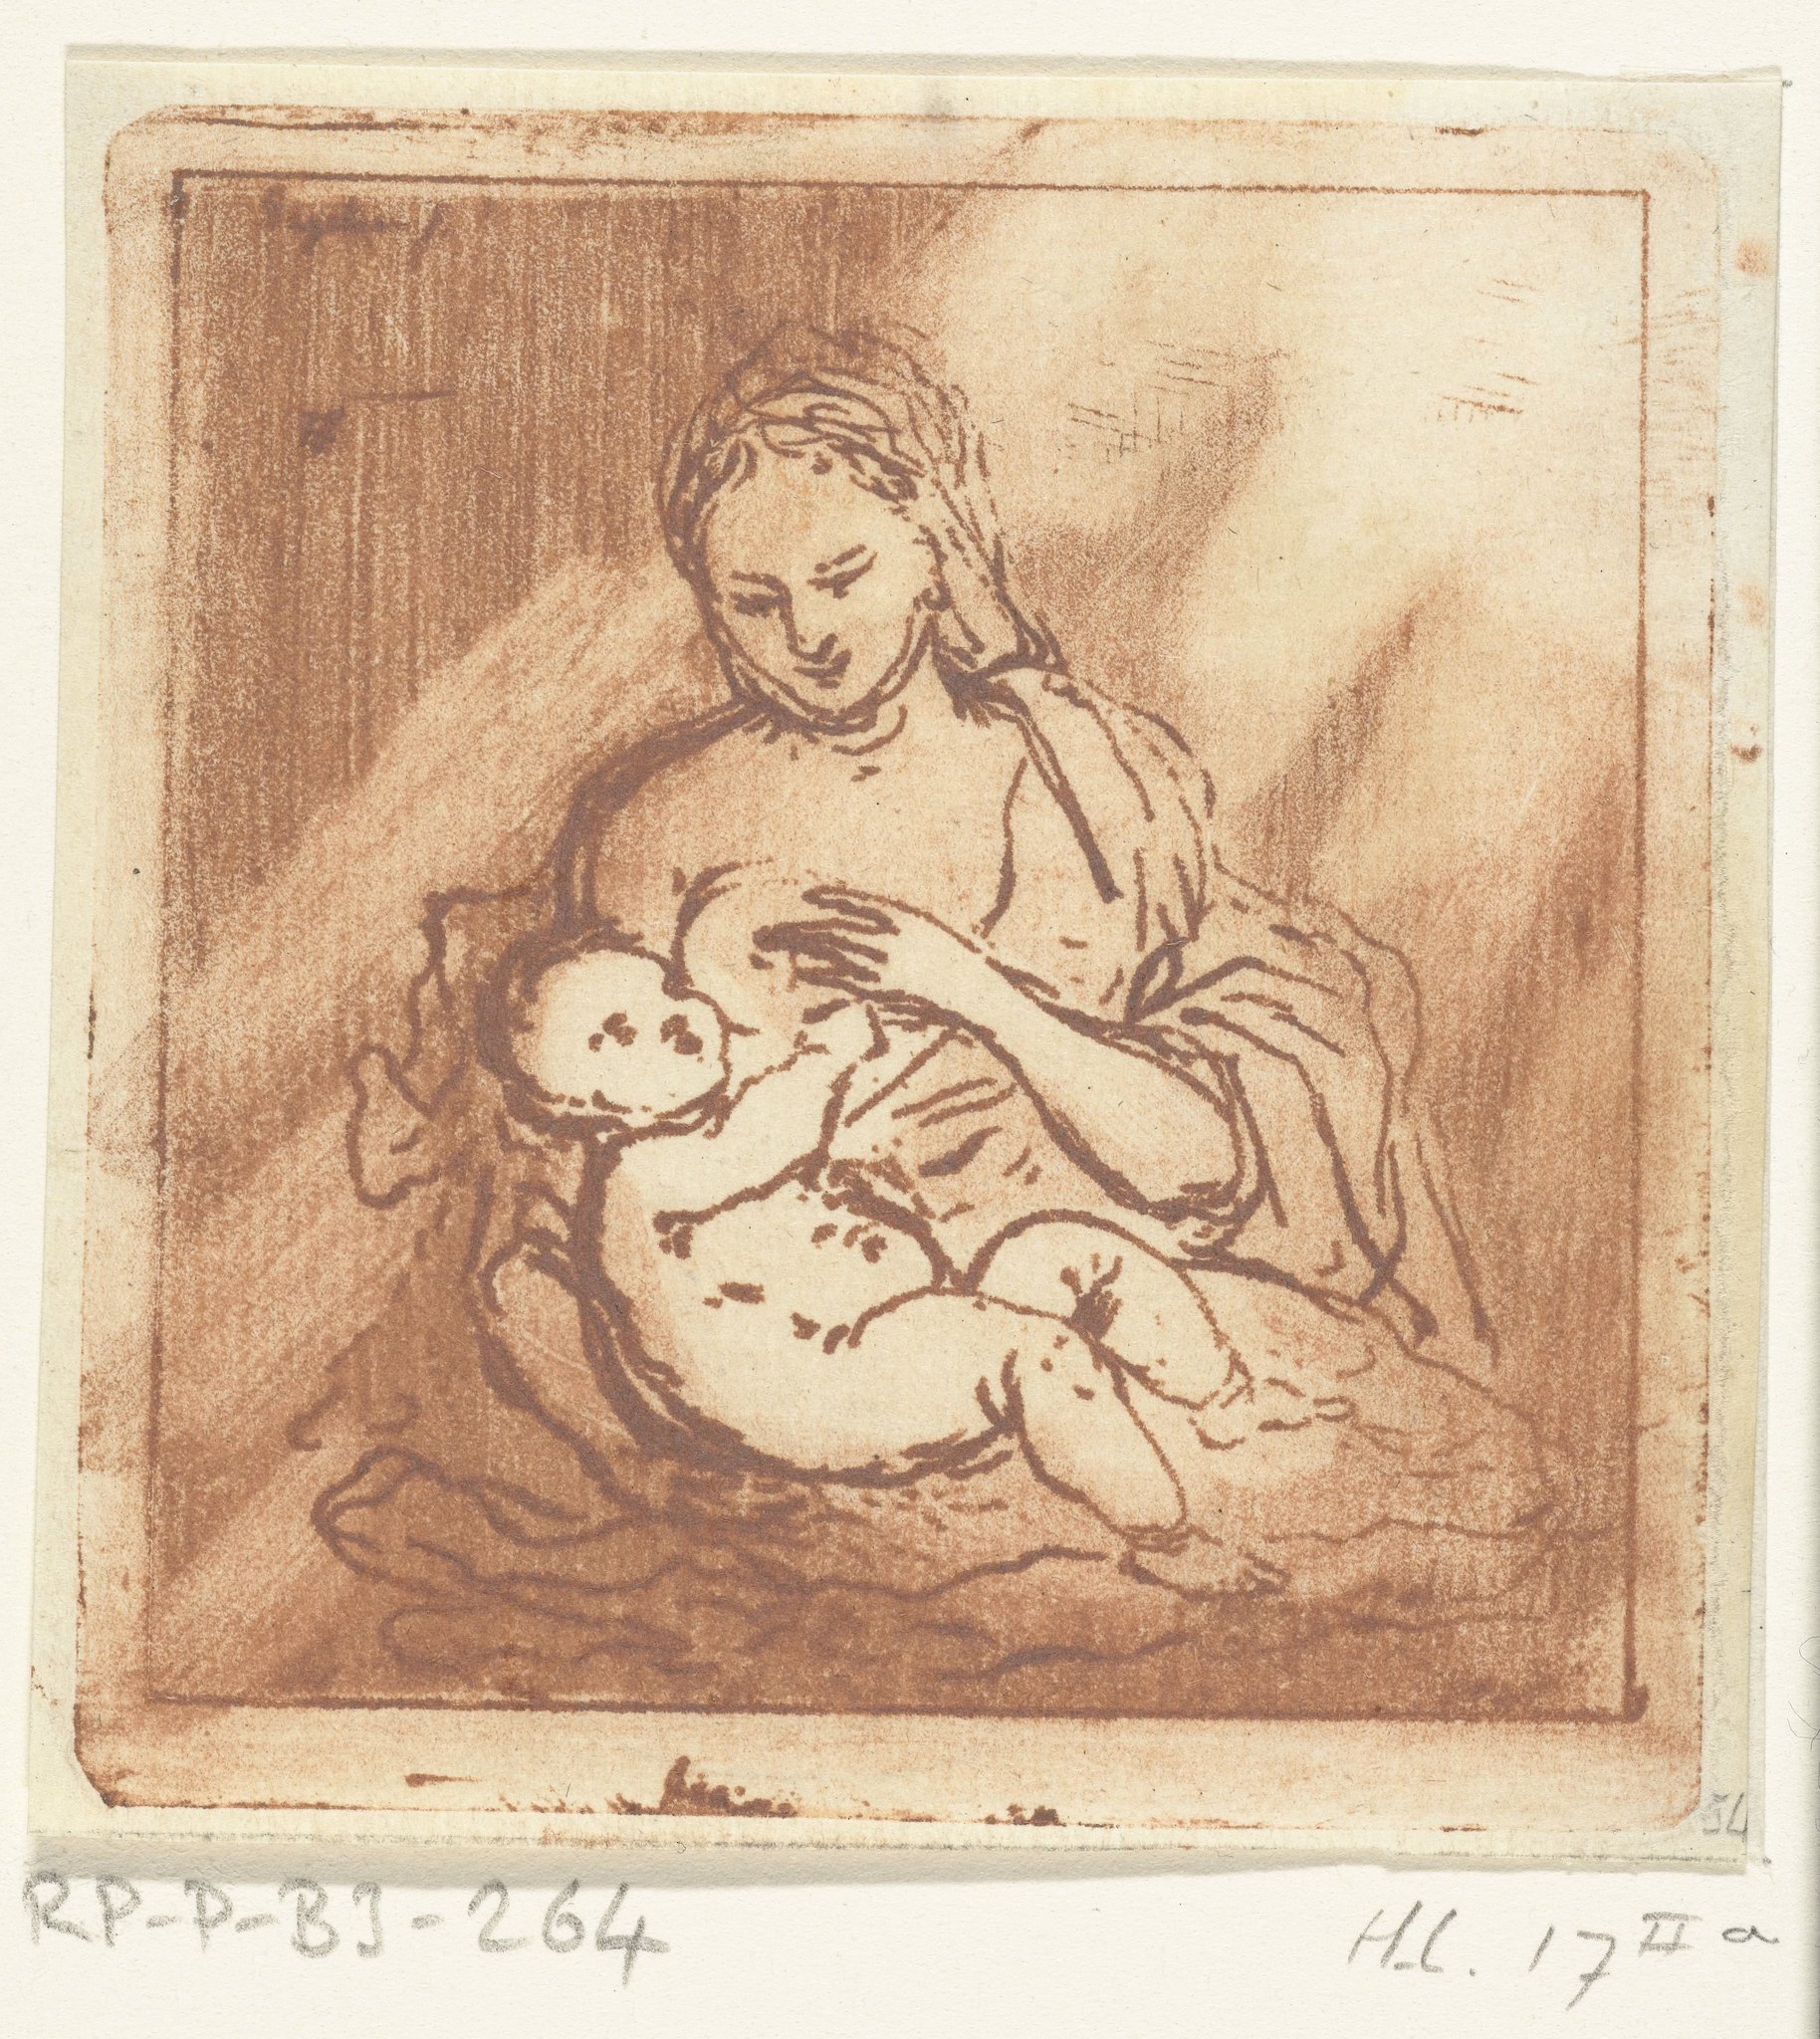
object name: print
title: Maria geeft Christus de borst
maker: ernst willem jan bagelaar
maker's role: draughtsman, print maker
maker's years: 1775-1837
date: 1798-1837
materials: paper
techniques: printmaking, etching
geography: netherlands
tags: christ-child suckling, or beginning to suckle, e.g. mary uncovering her breast ~ madonna-representations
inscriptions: collector's mark: Lugt 2228